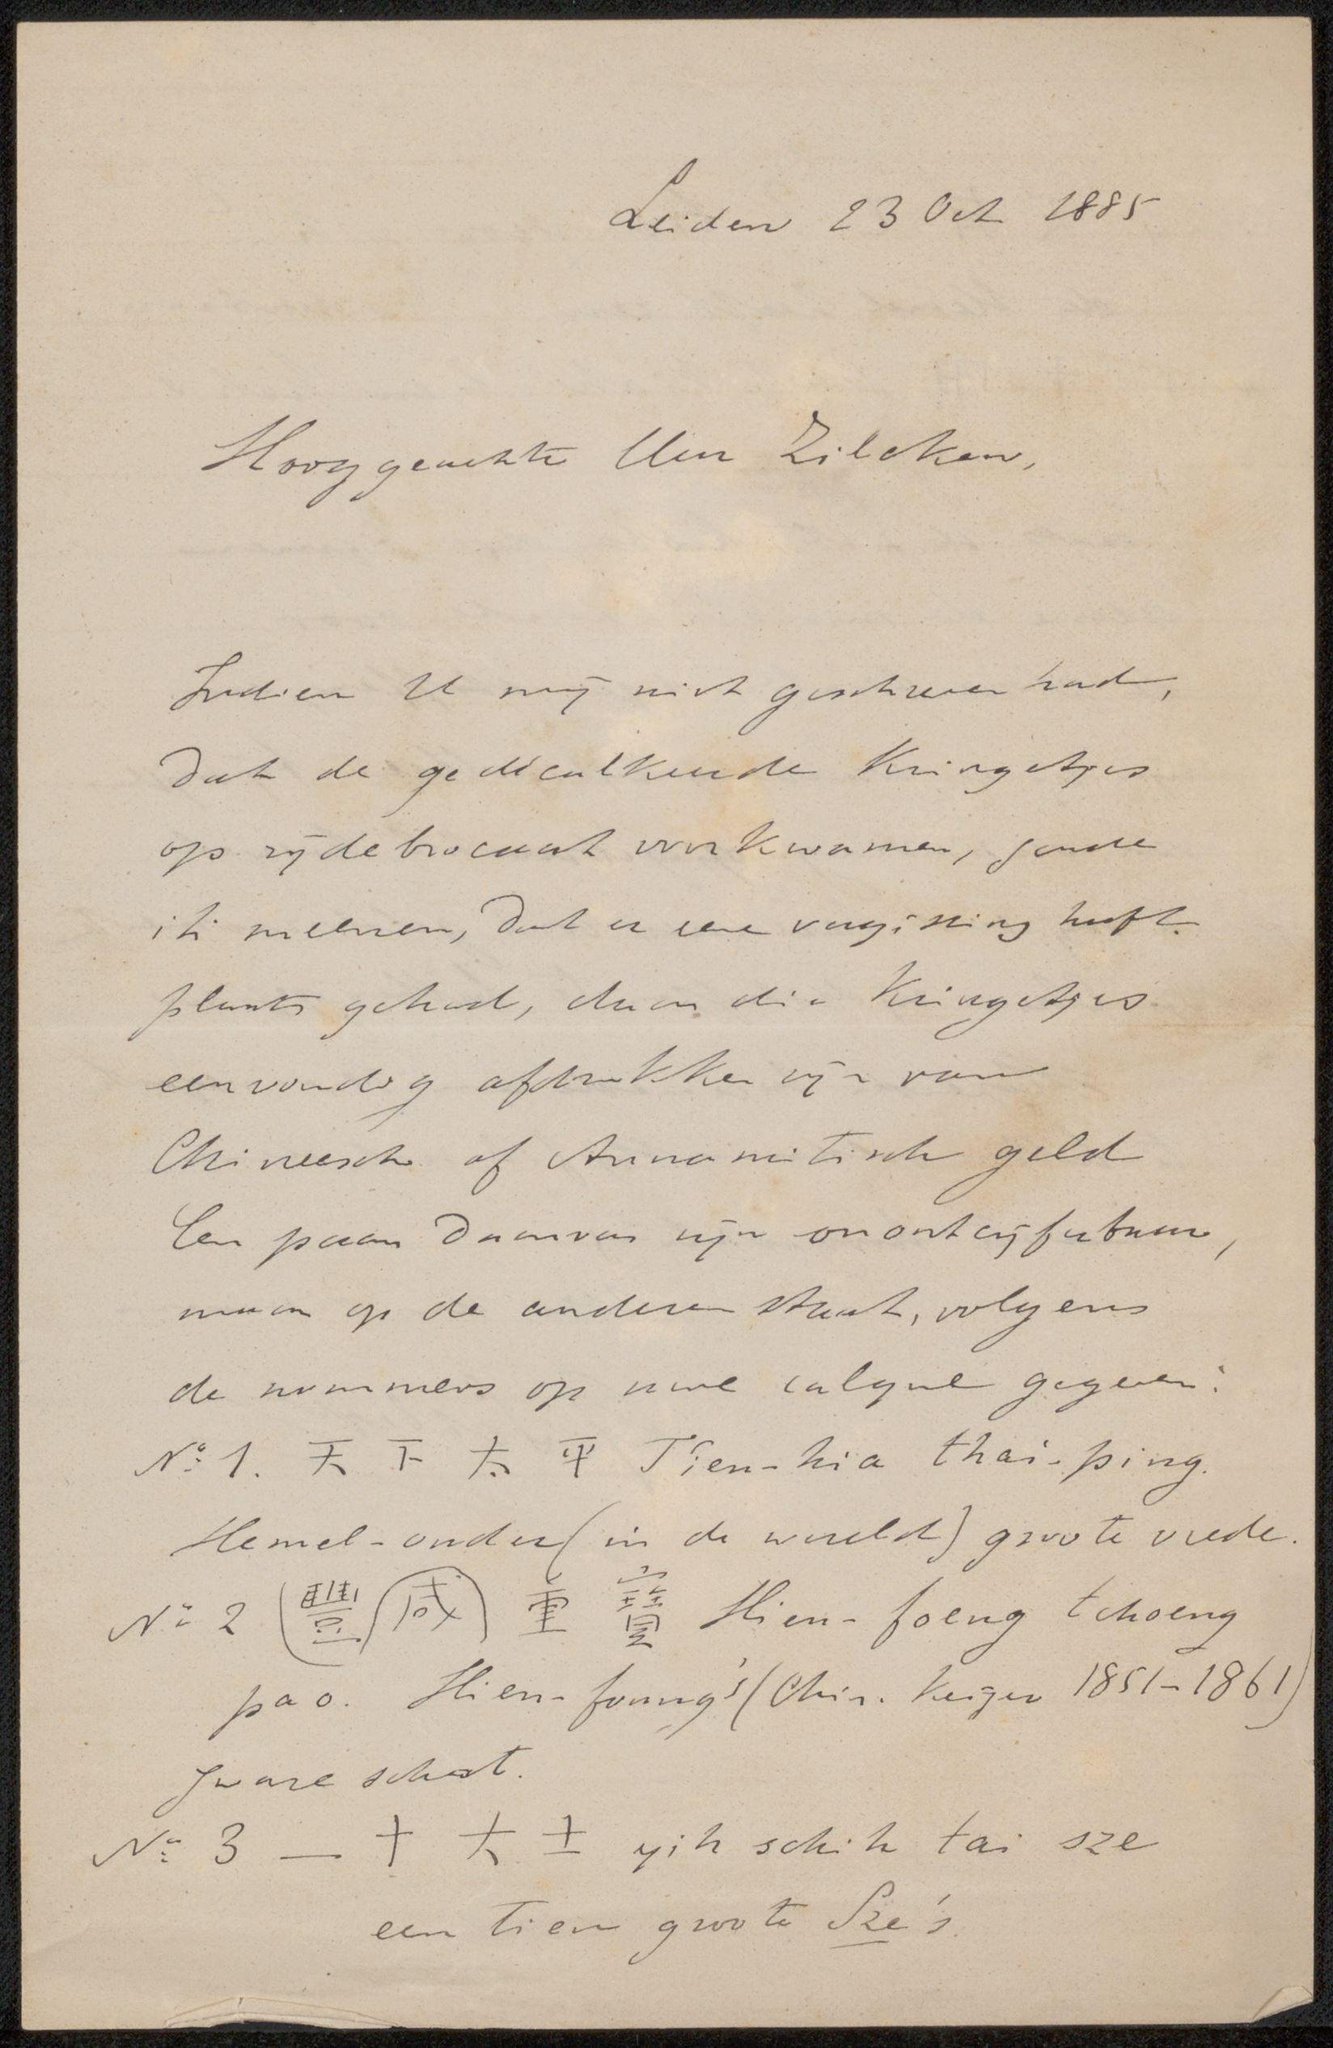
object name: letter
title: Brief aan Philip Zilcken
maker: gustaaf schlegel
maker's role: hoogleraar, sinoloog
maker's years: 1840-1903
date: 1885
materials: ink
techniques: pen, writing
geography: leiden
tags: painter, philip zilcken, applied arts, arts and crafts; industrial design, money, china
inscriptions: collector's mark: ‘RPK’